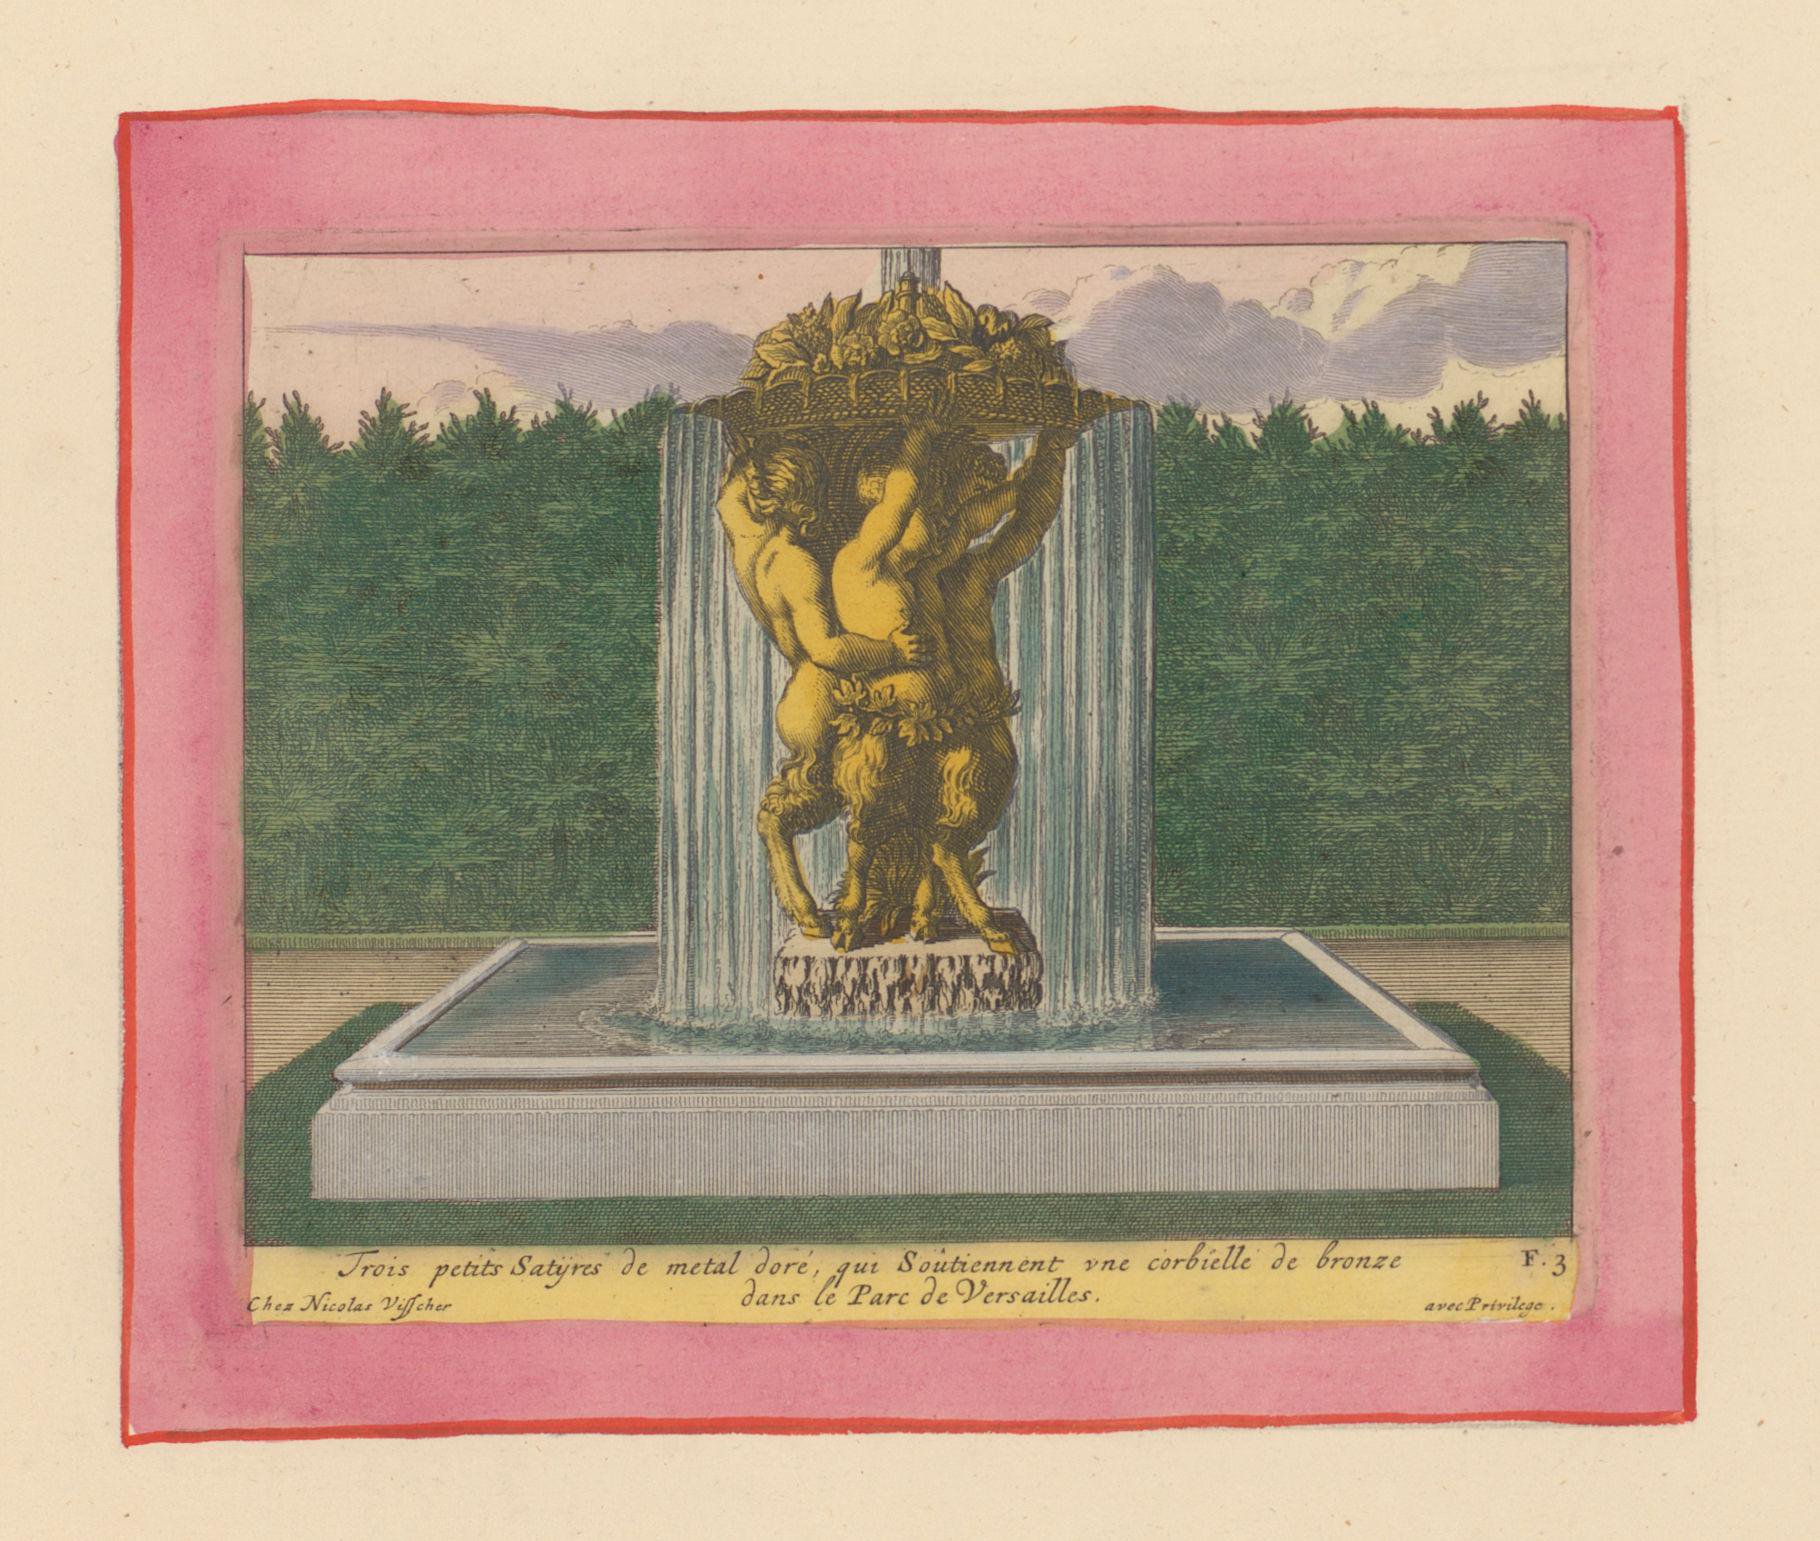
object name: print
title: Fontein met een beeld van drie saters die een mand boven hun hoofden dragen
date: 1686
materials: paper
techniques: etching, hand coloring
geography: amsterdam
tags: garden fountain, satyr(s) (in general), statues, sculptures in garden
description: Fontein met een beeld van drie saters van goudmetaal die een bronzen mand boven hun hoofden dragen in de tuinen van Versailles. Rechtsonder het serienummer: F3. Prent maakt deel uit van een album.